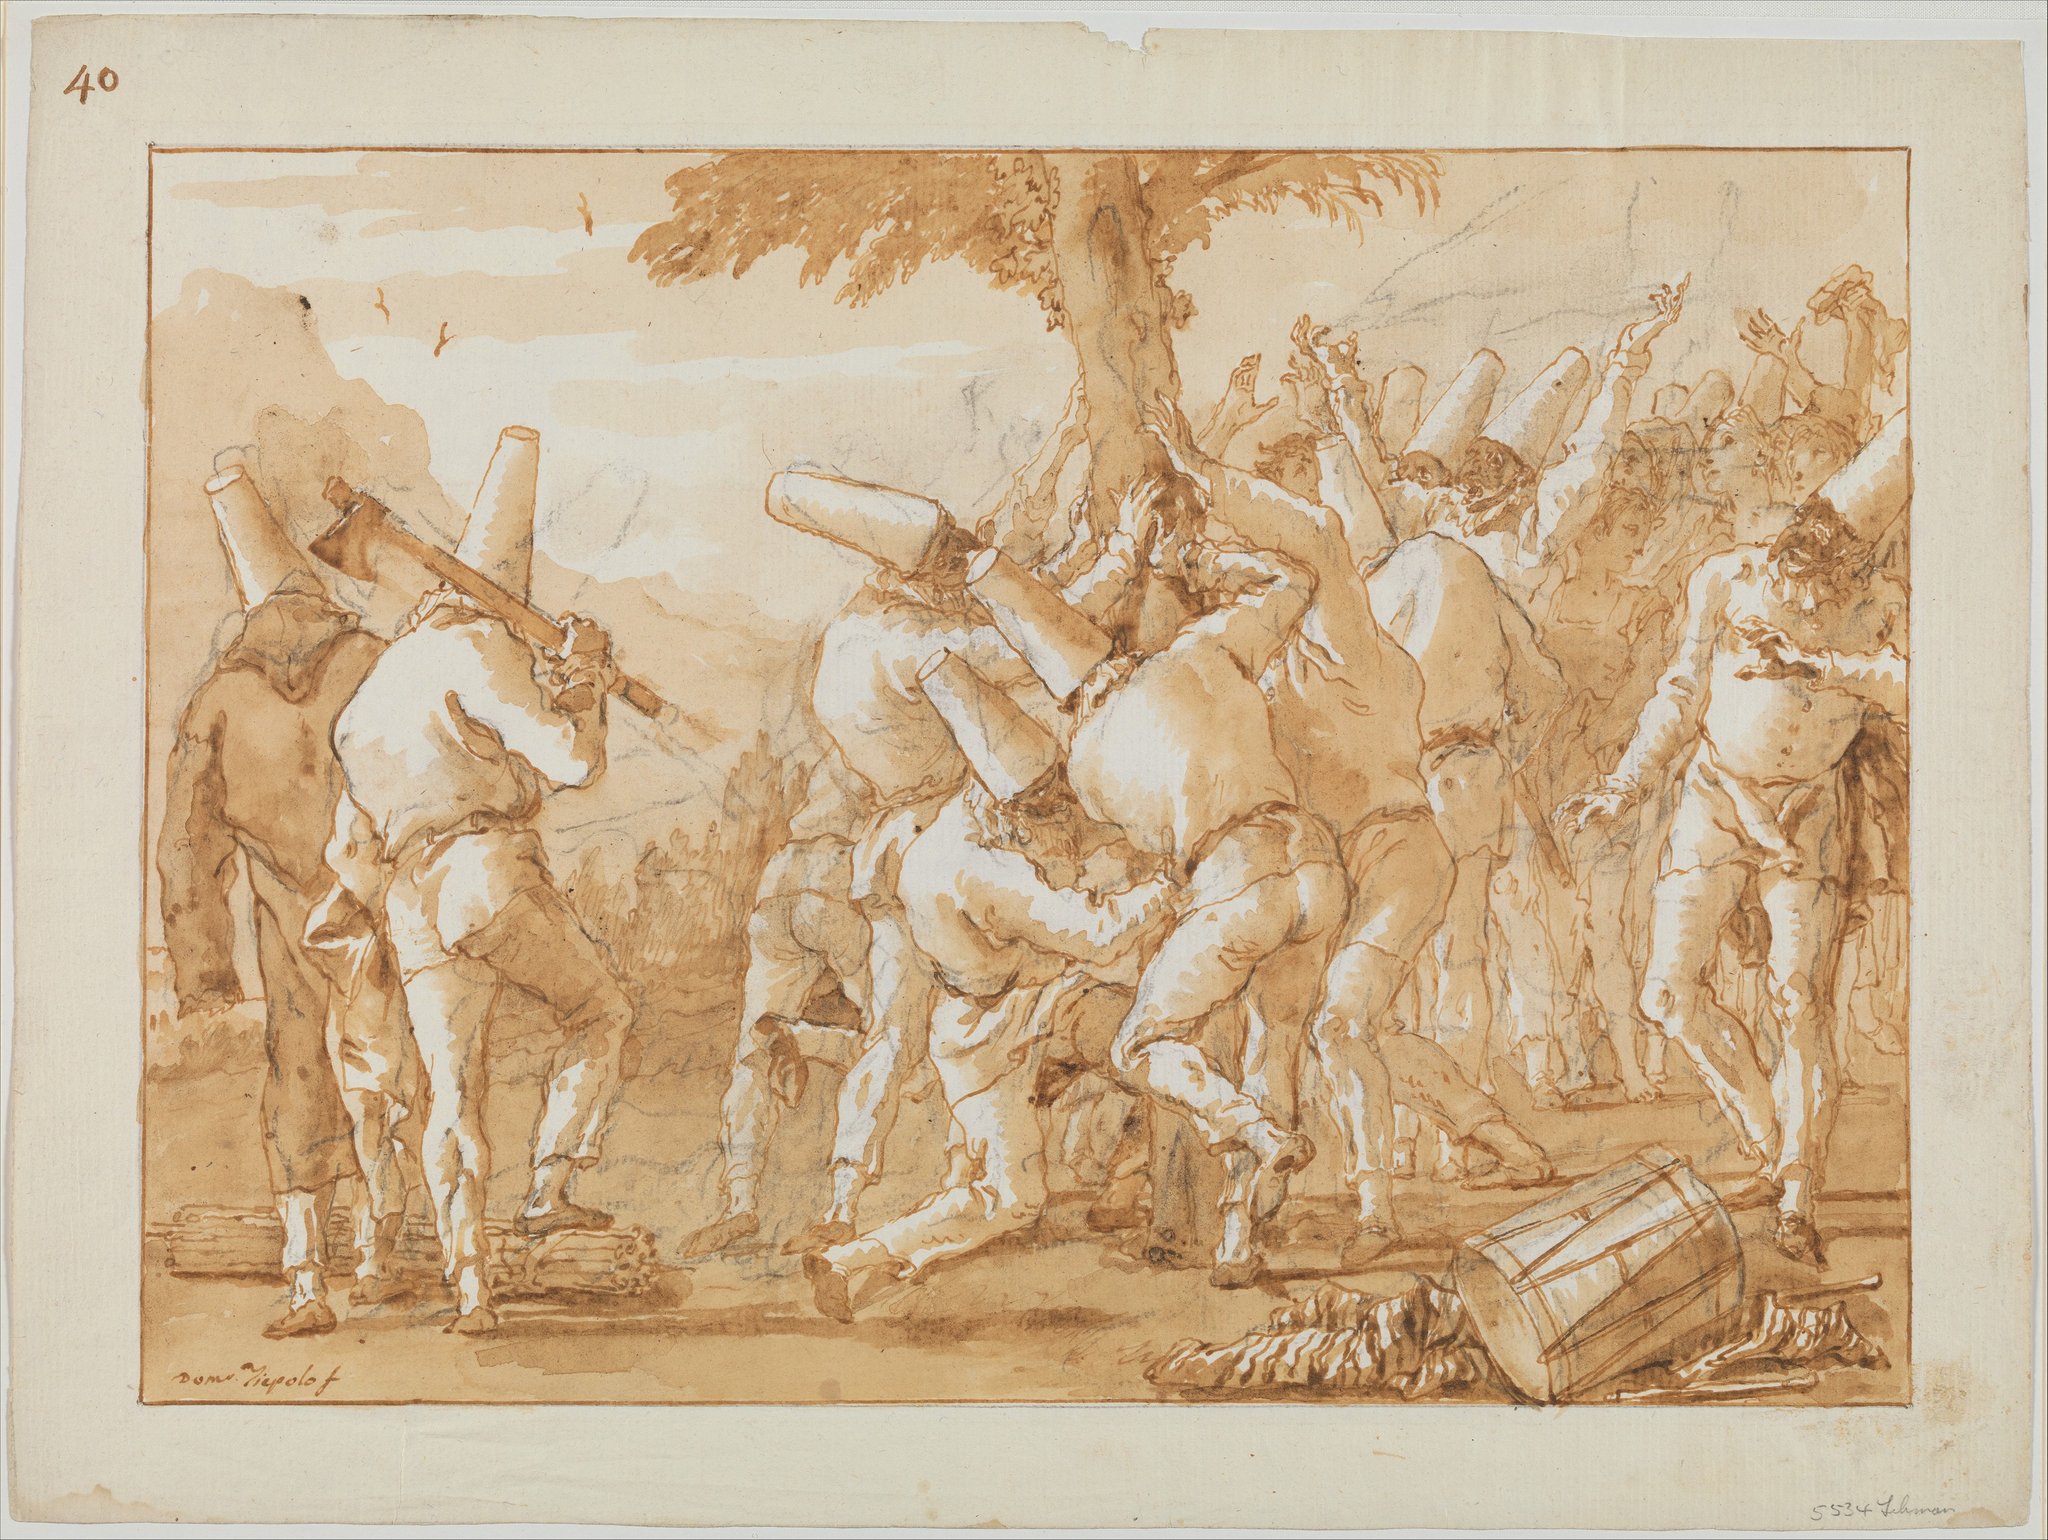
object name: drawing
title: Punchinellos Felling (or Planting) a Tree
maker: giovanni domenico tiepolo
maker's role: artist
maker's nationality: italian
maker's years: 1727-1804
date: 1767-1833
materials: chalk, ink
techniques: pen, wash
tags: men,trees